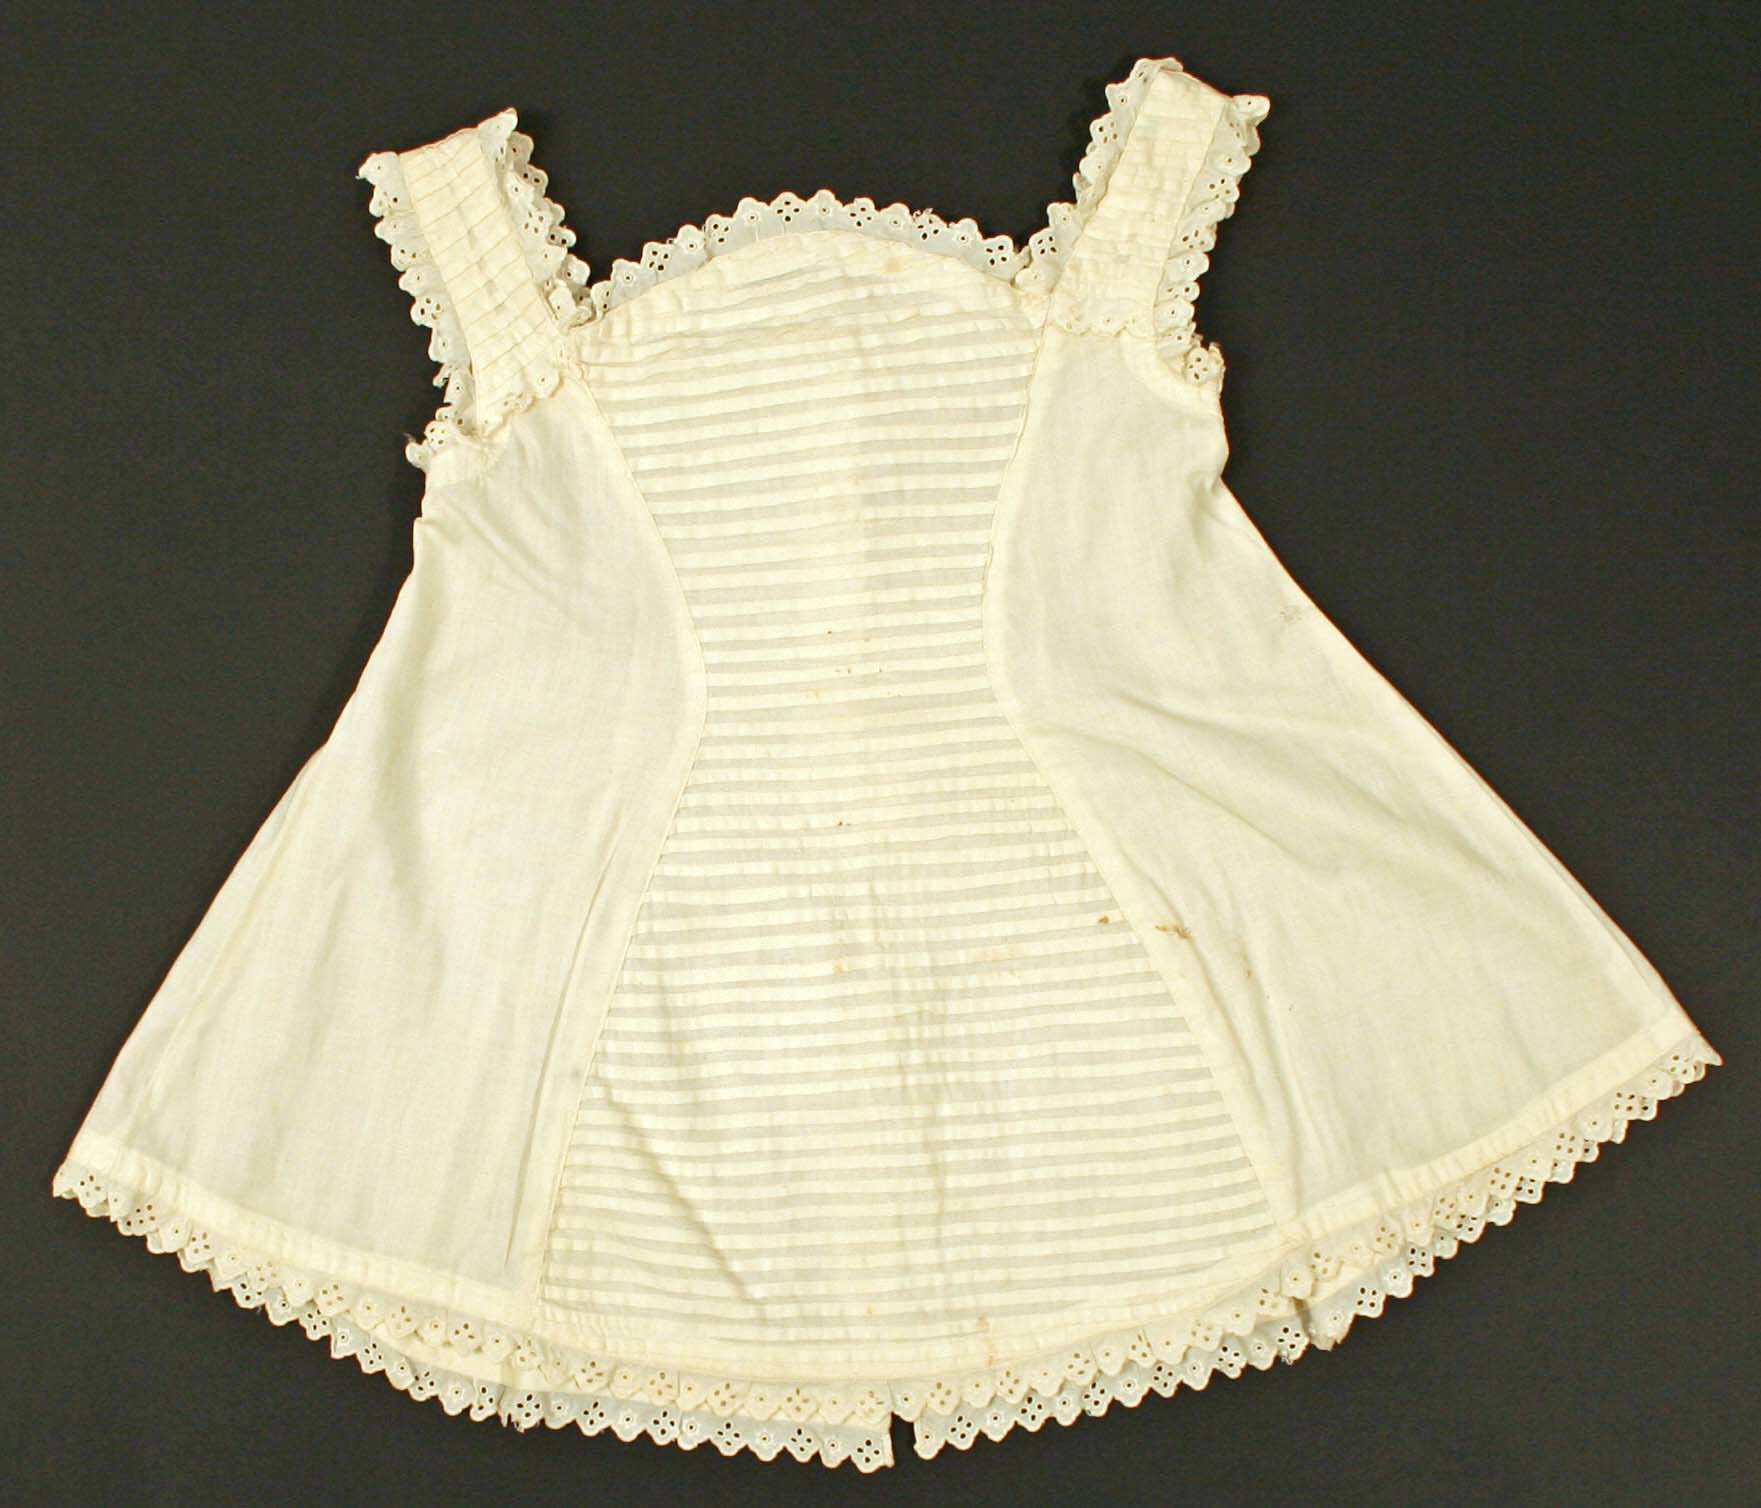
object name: pinafore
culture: american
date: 1825-1875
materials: cotton